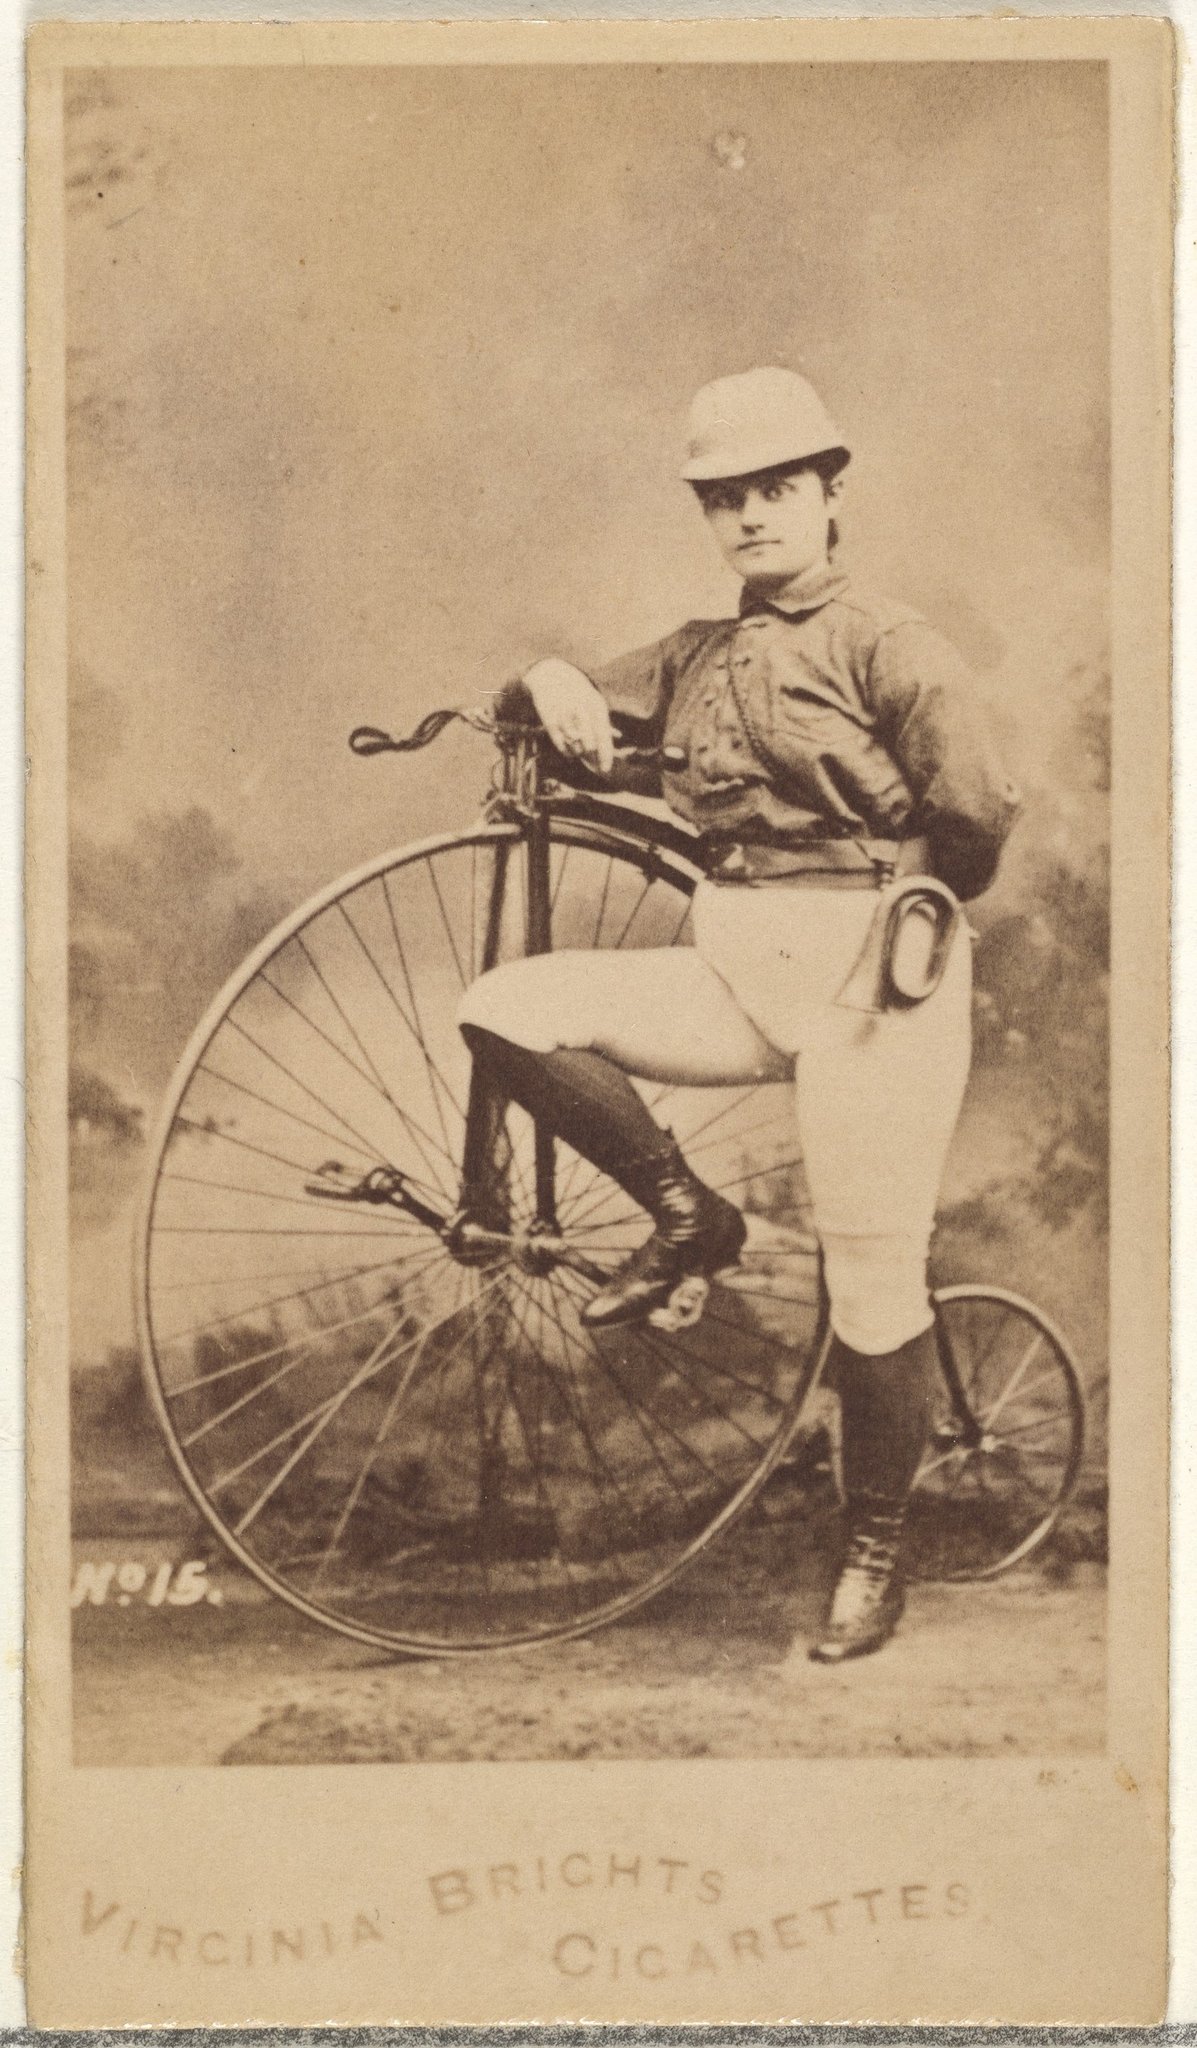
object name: photograph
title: Card 15, from the Girl Cyclists series (N49) for Virginia Brights Cigarettes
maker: allen & ginter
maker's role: publisher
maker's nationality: american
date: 1887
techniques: albumen silver print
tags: portraits,women,bicycles